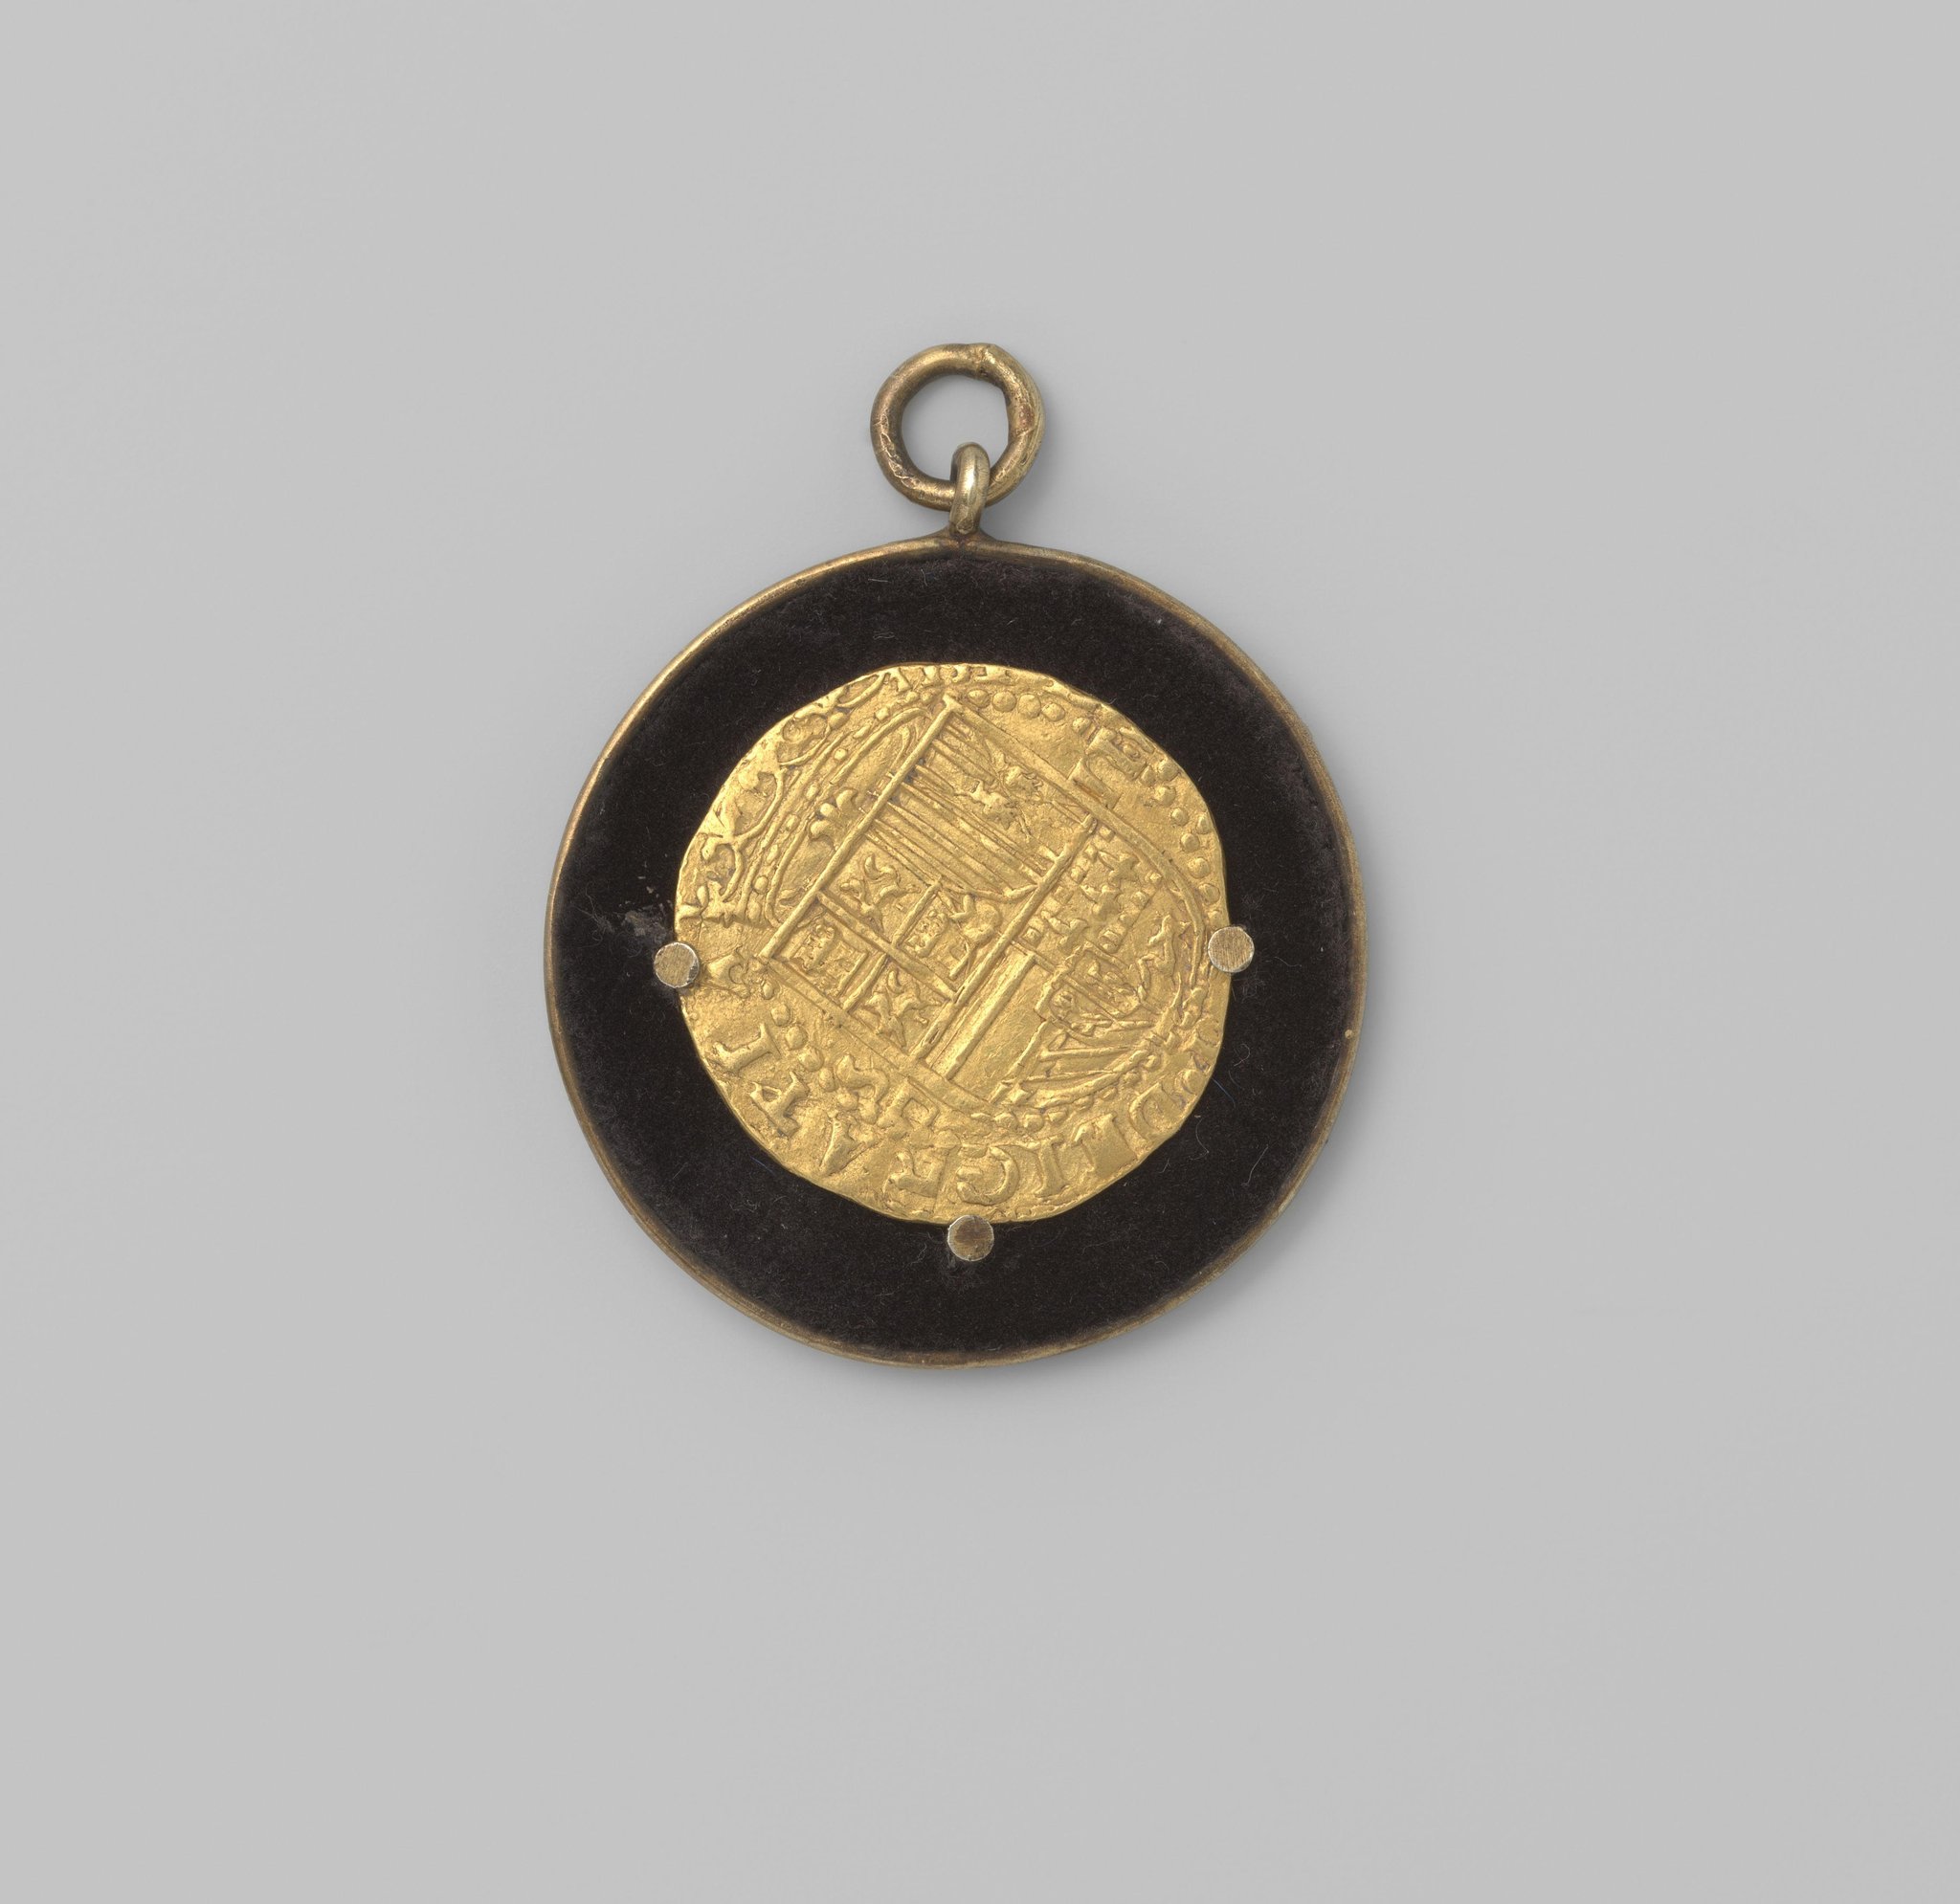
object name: dubbele escudo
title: Gouden dubbele escudo Philips II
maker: Anonymous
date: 1600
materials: gold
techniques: striking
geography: sevilla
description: Gouden handelsmunt afkomstig uit Nederlandse muntvondst.